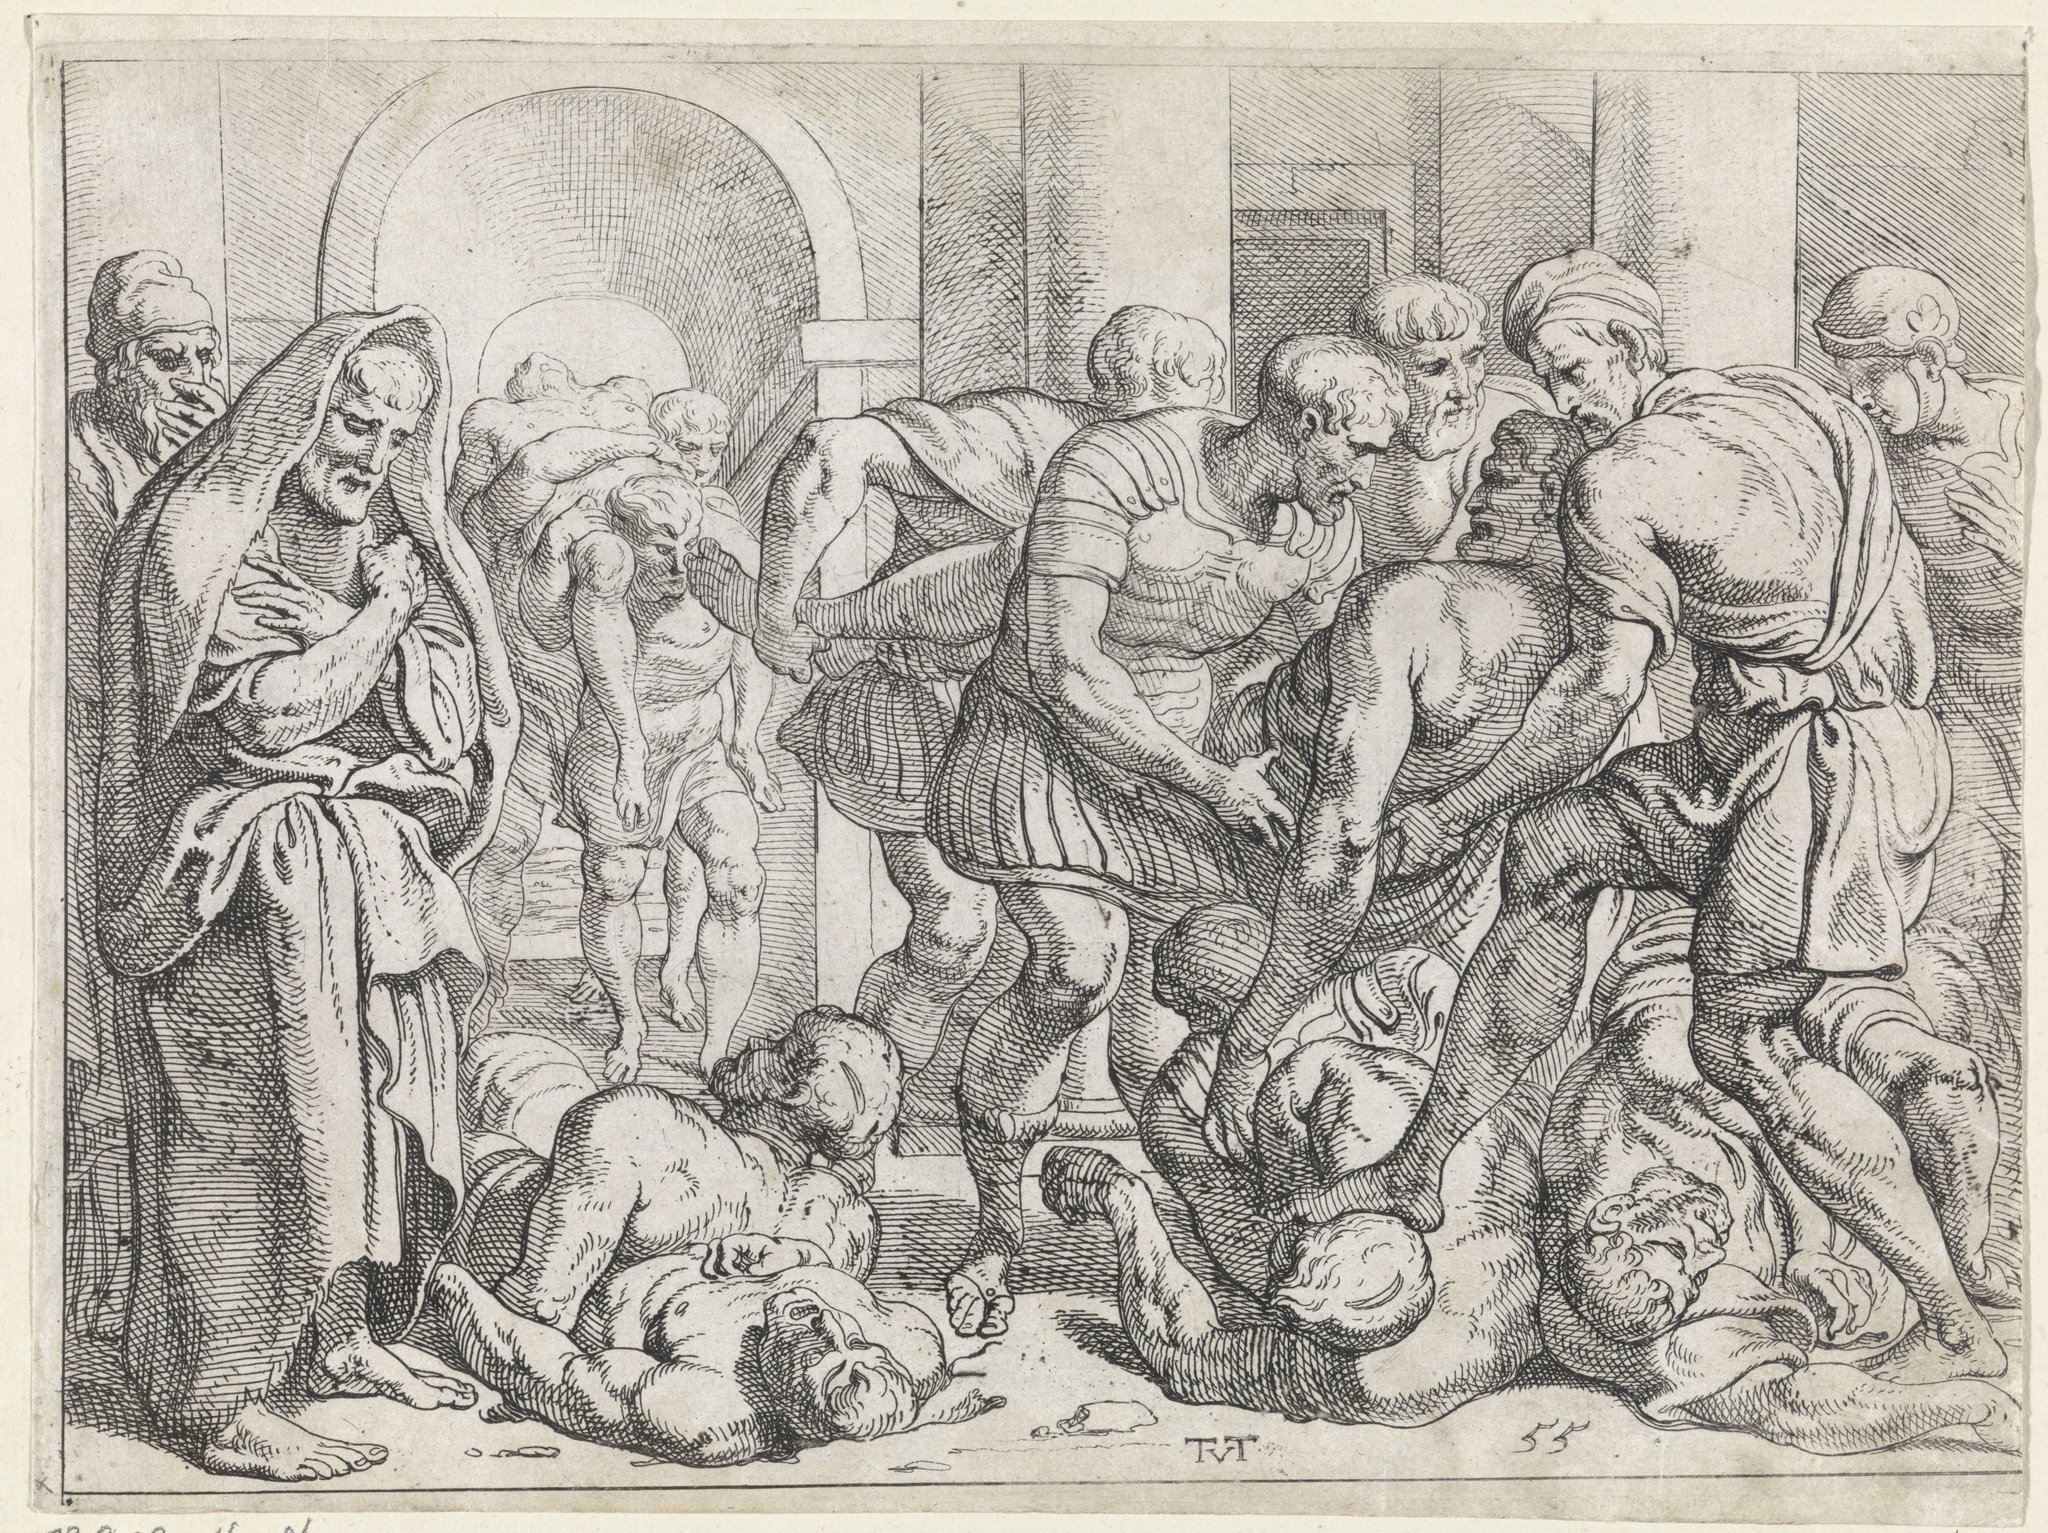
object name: print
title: Opruiming van de lichamen van de vrijers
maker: theodoor van thulden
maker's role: draughtsman, painter, print maker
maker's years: 1606-1669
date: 1632-1633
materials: paper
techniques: engraving, etching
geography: paris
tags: sequel to the death of the suitors (homer, odyssey xxiv)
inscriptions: collector's mark: Lugt 2228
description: De familieleden van de door Odysseus gedode vrijers tillen de lijken weg om ze te begraven.